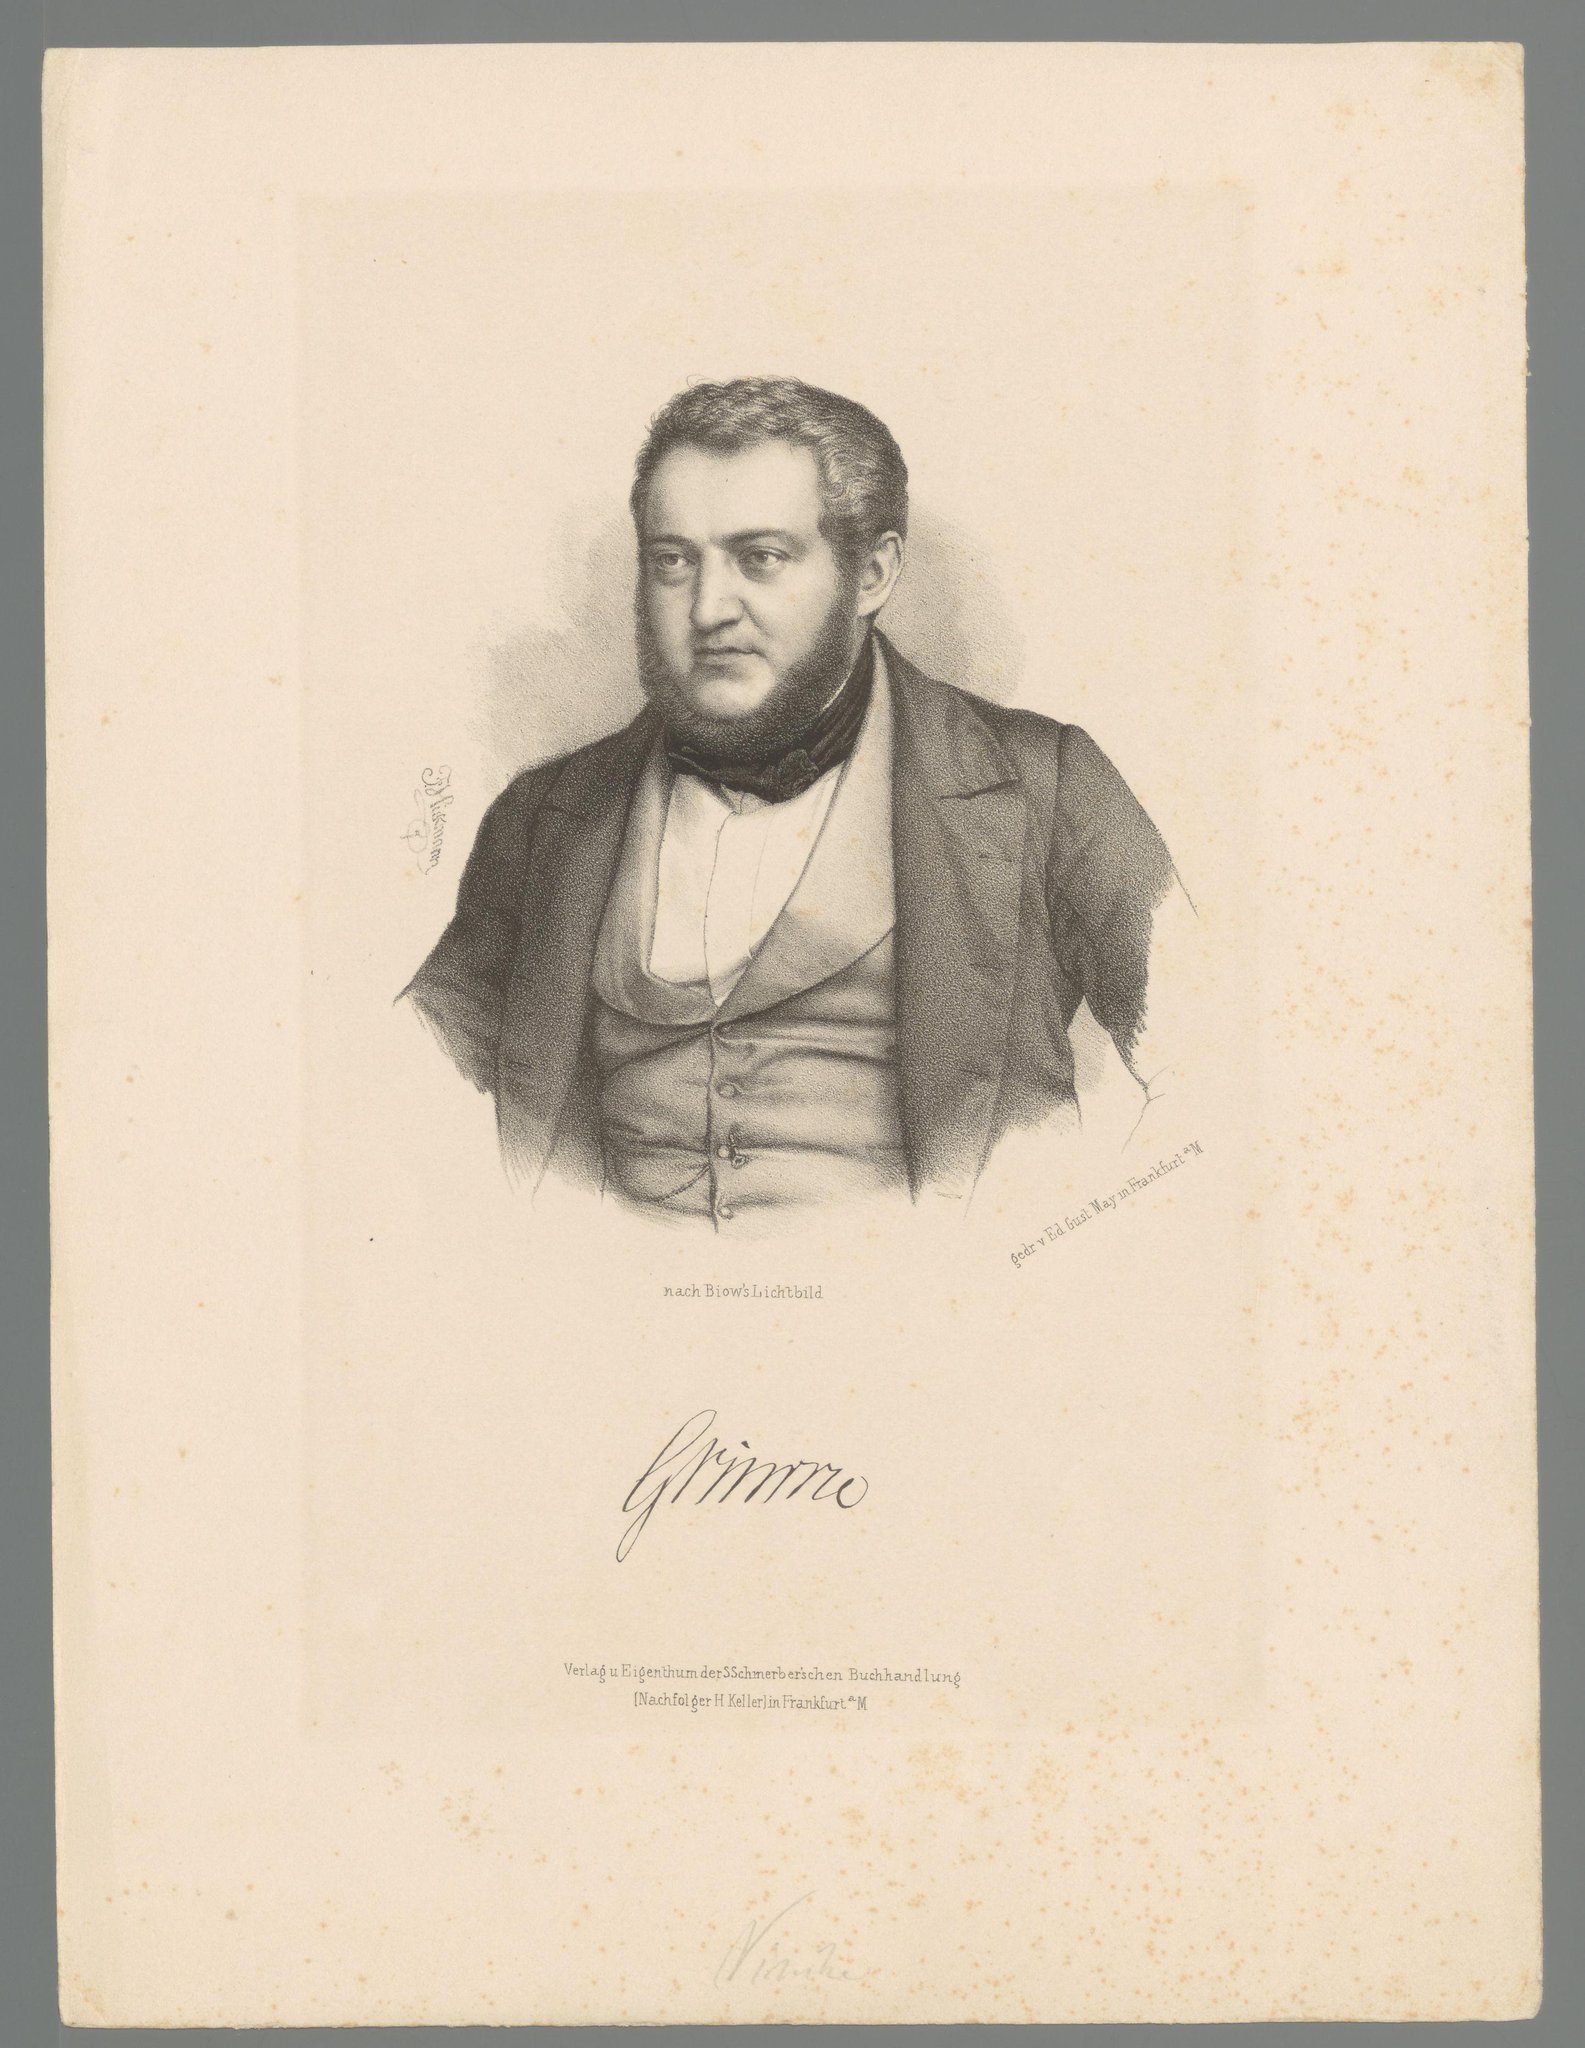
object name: print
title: Portret van Georg von Vincke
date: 1830-1900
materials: paper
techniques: lithograph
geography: frankfurt am main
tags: historical persons, politician, e.g. party leader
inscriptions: collector's mark: Lugt 2228